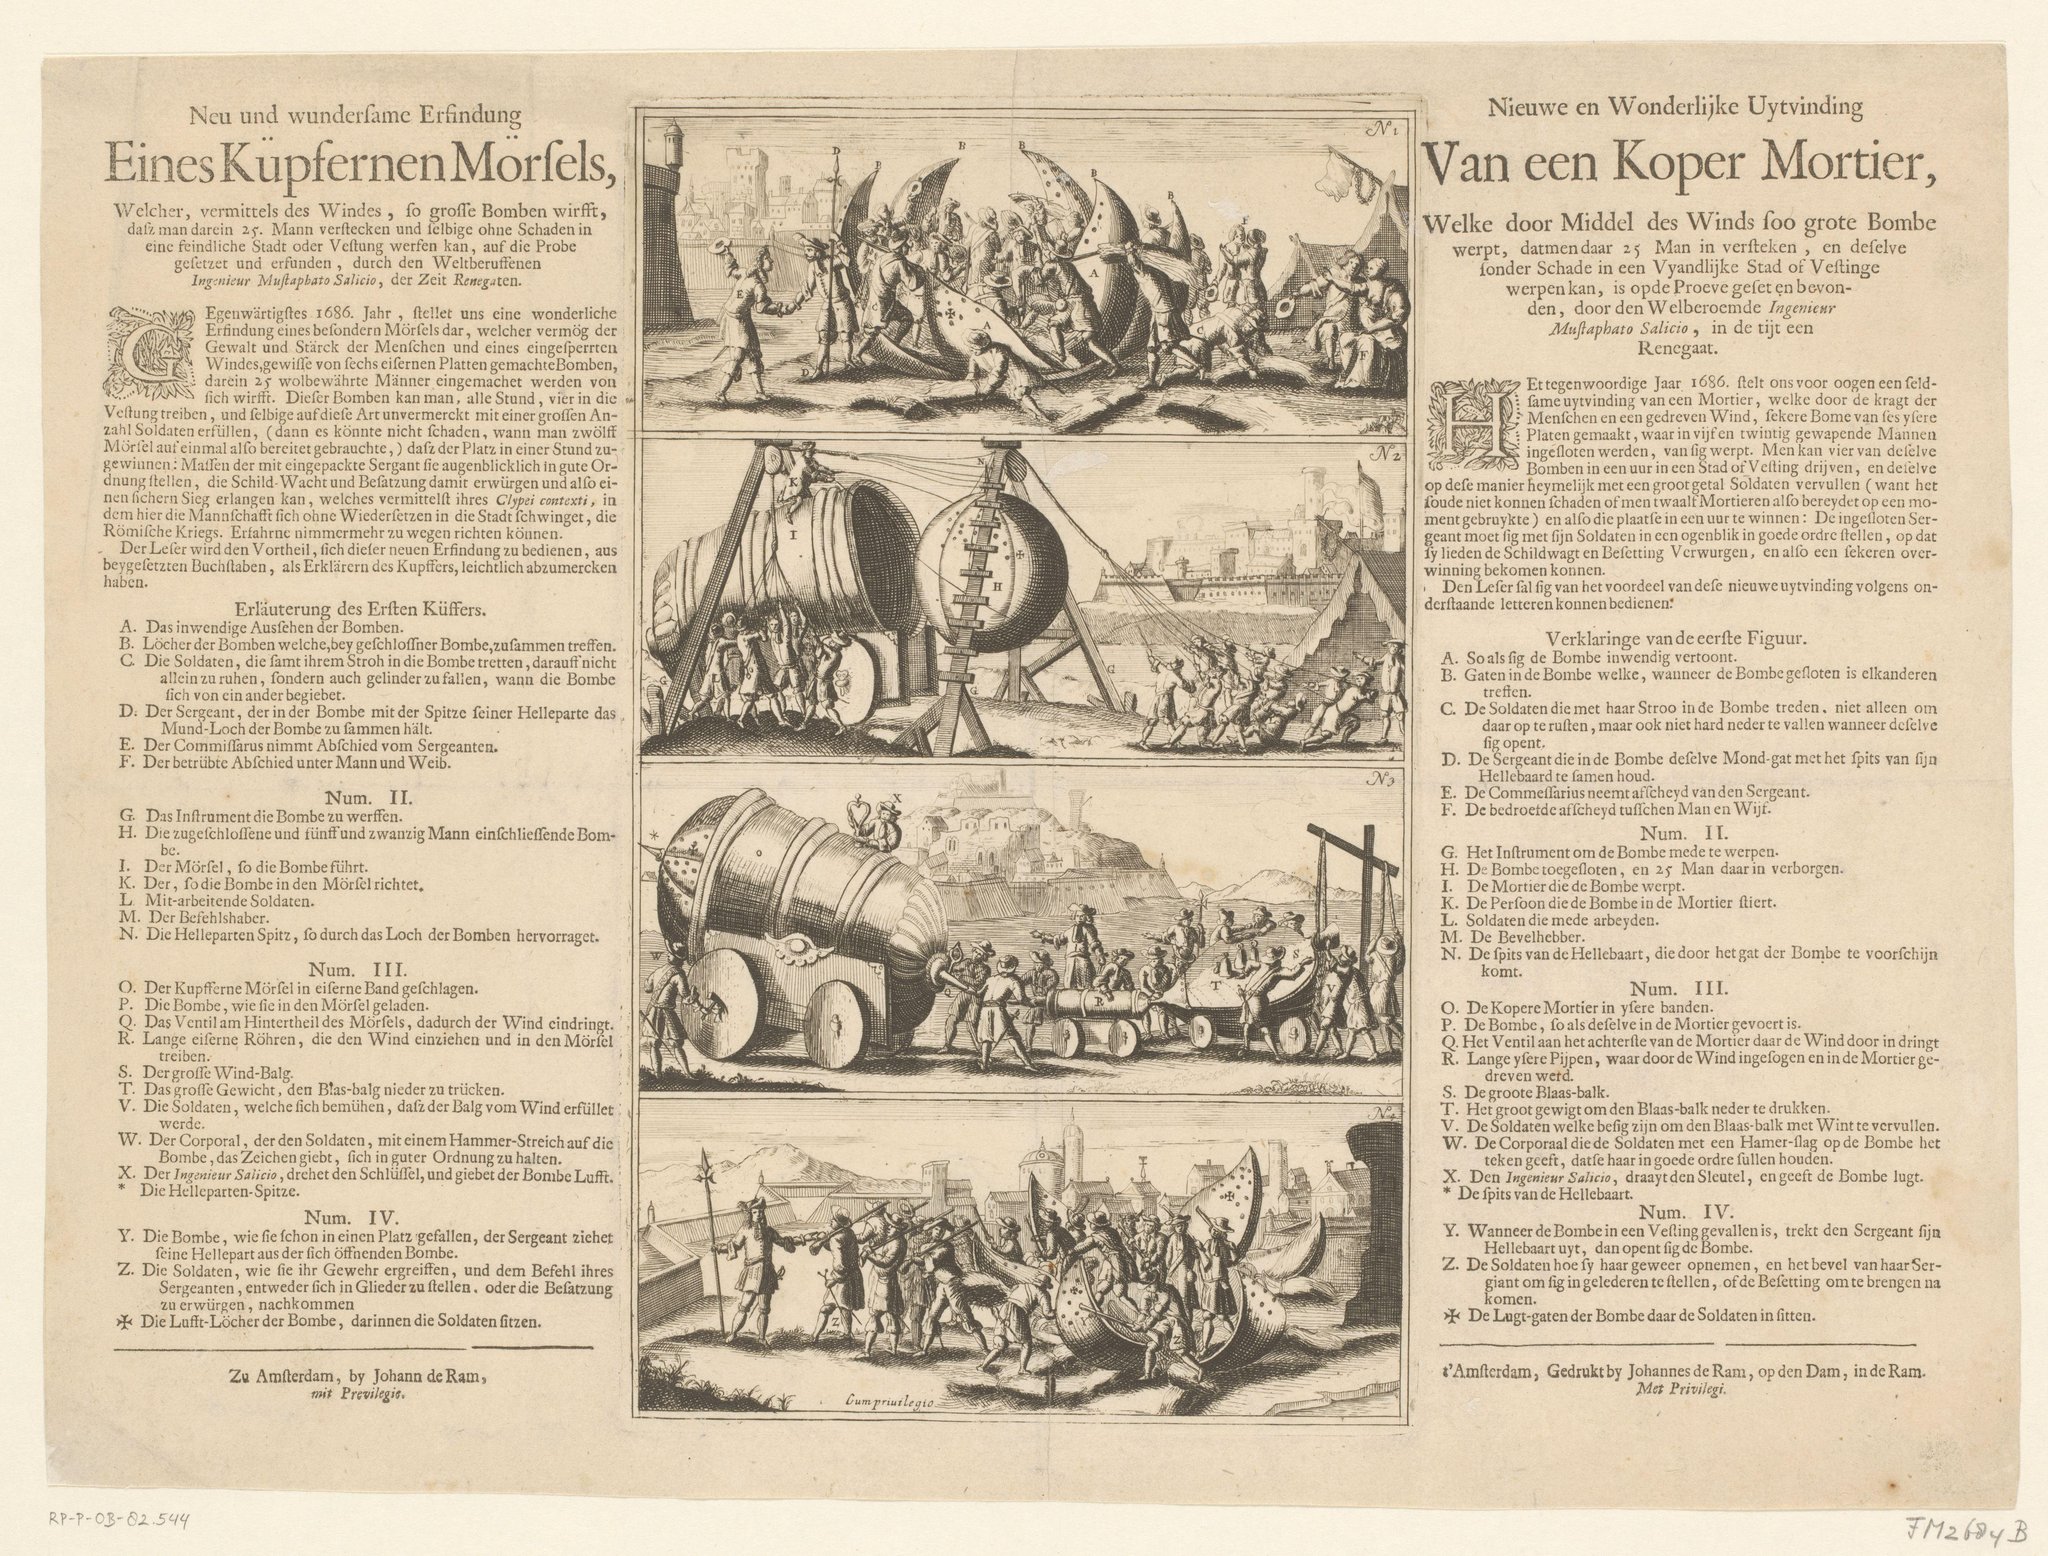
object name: print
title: Neu und wundersame Erfindung Eines Küpfernen Mörsels (...) / Nieuwe en Wonderlijke Uytvinding Van een Koper Mortier, Welke door Middel des Winds soo grote Bombe werpt, datmen daar 25 Man in versteken, en deselve sonder Schade in een Vyandlijke Stad of Vestinge werpen kan (...)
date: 1686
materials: paper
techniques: engraving, etching, letterpress printing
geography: northern netherlands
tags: technology (+ invention ~ scientific research), firearms: cannon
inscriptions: date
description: Wonderlijk uitvinding uit 1686 door de ingenieur Mustaphato Salicio van een koperen mortier waarmee 25 soldaten in een afgesloten bol door de lucht binnen vijandelijke muren geschoten kunnen worden. Plaat met vier genummerde voorstellingen van het laden, afschieten en veilig landen van de soldaten. Met links en rechts beschrijvingen in het Duits en Nederlands.